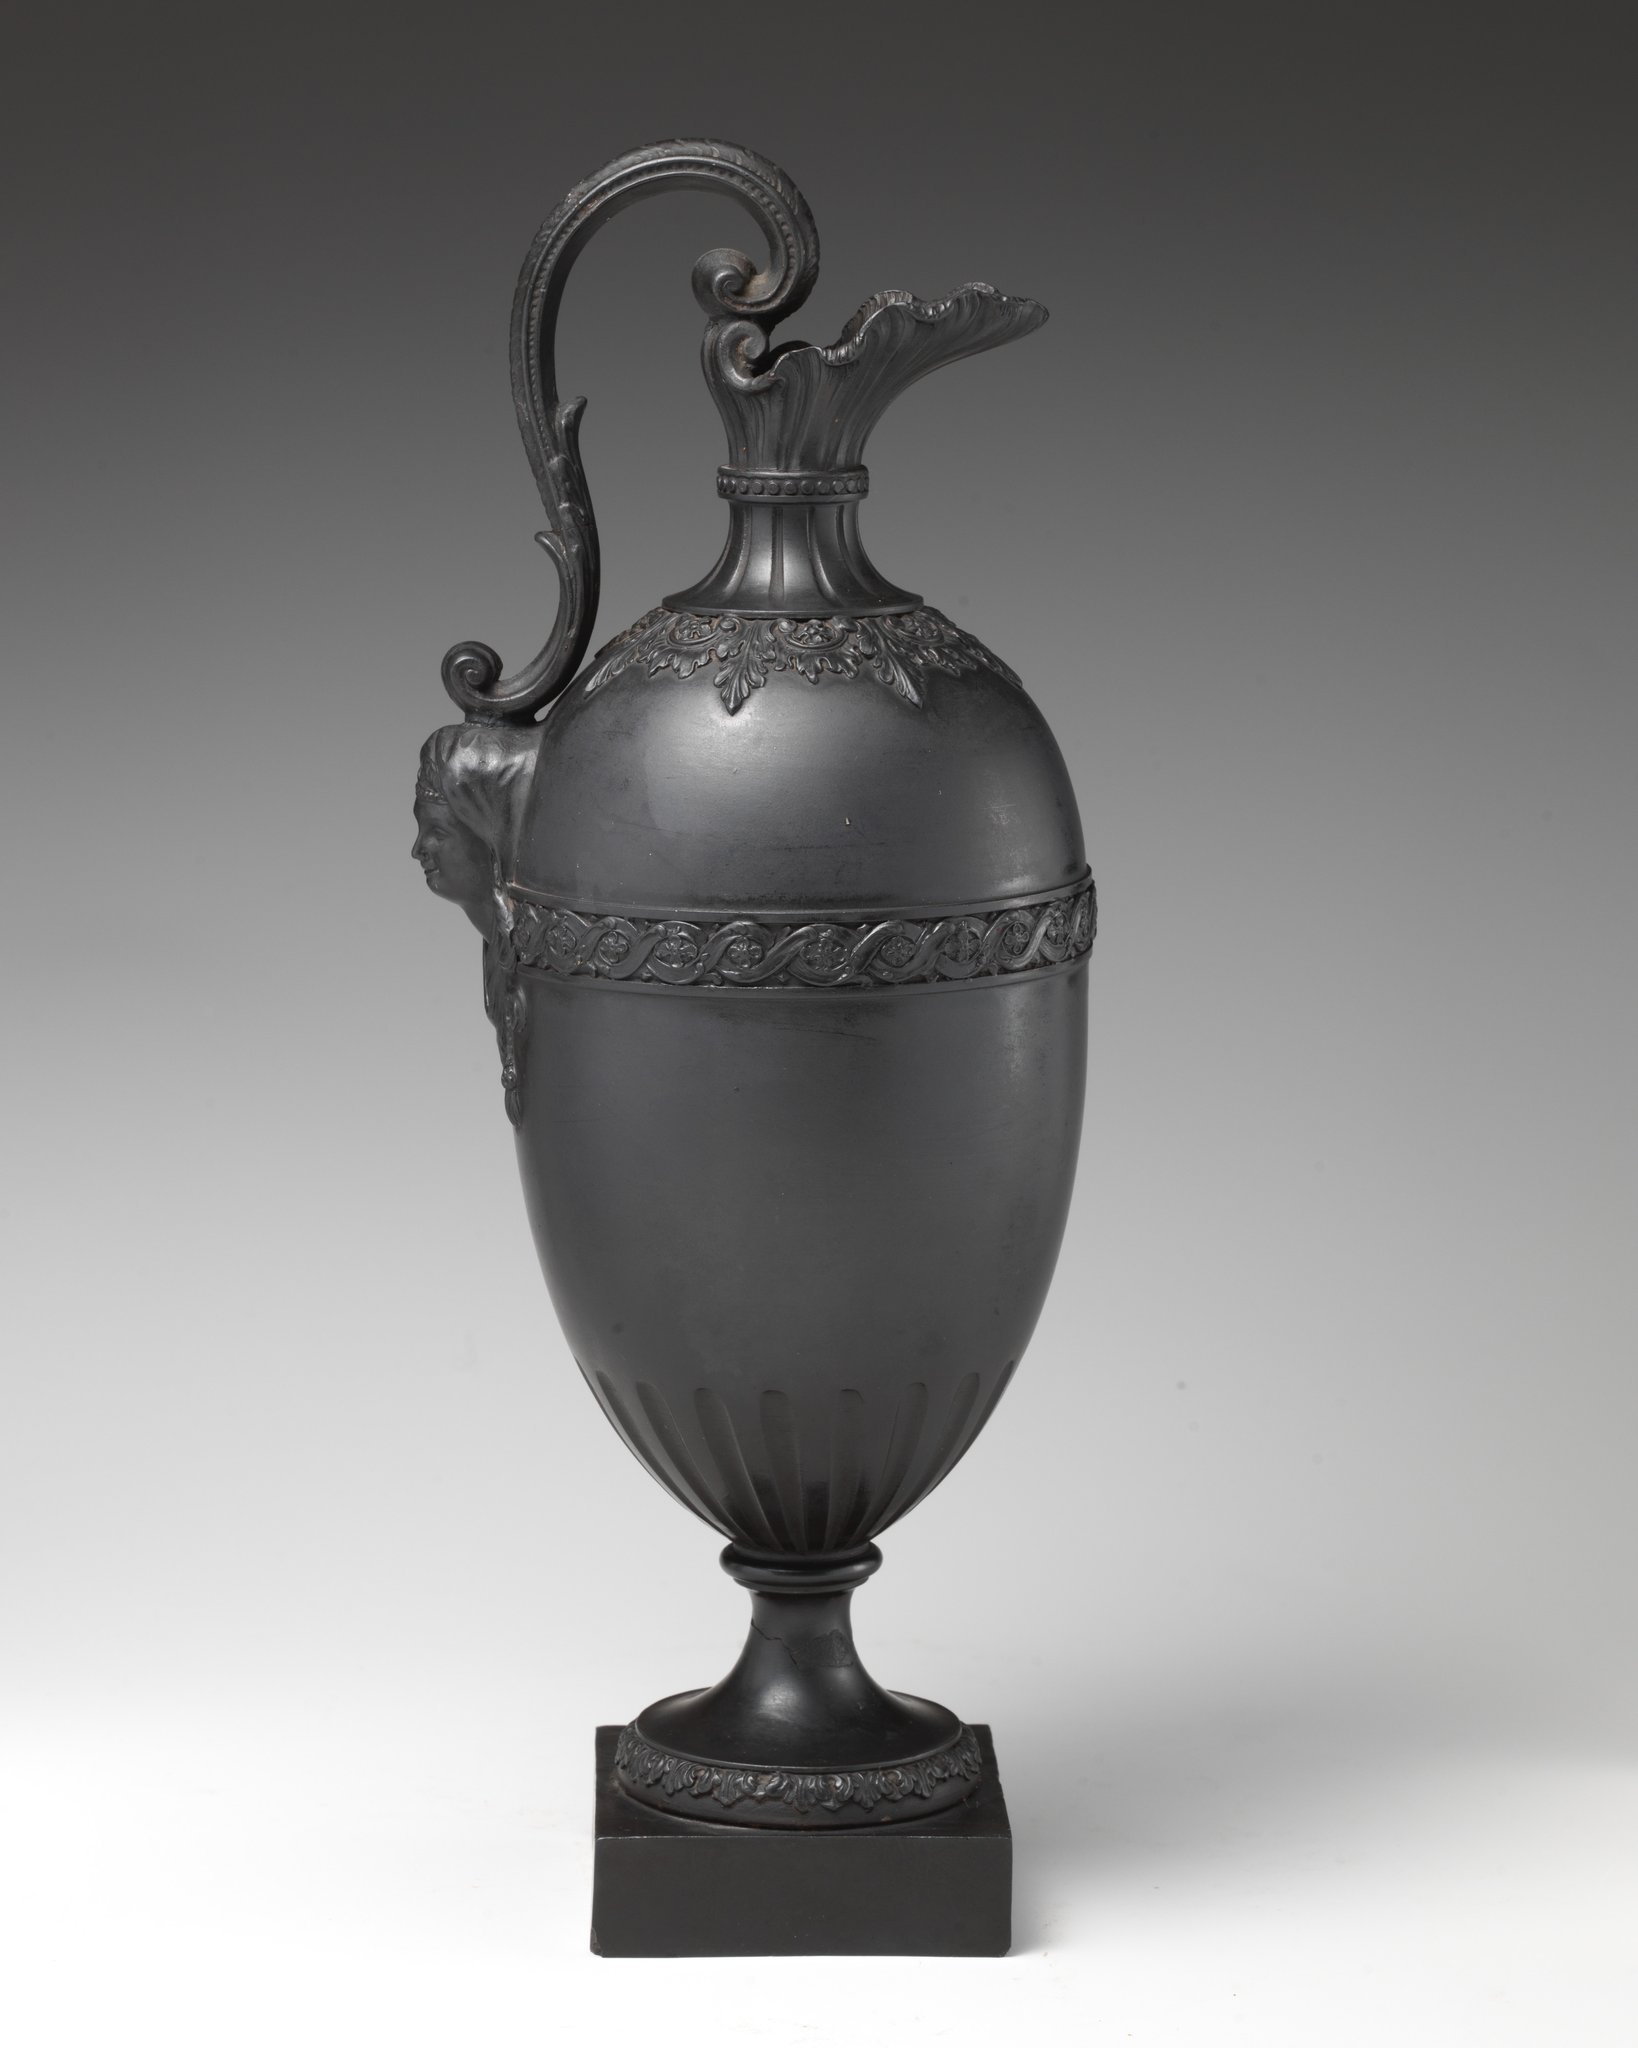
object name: ewer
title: Ewer (one of a pair)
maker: church works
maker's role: factory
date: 1778-1792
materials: stone